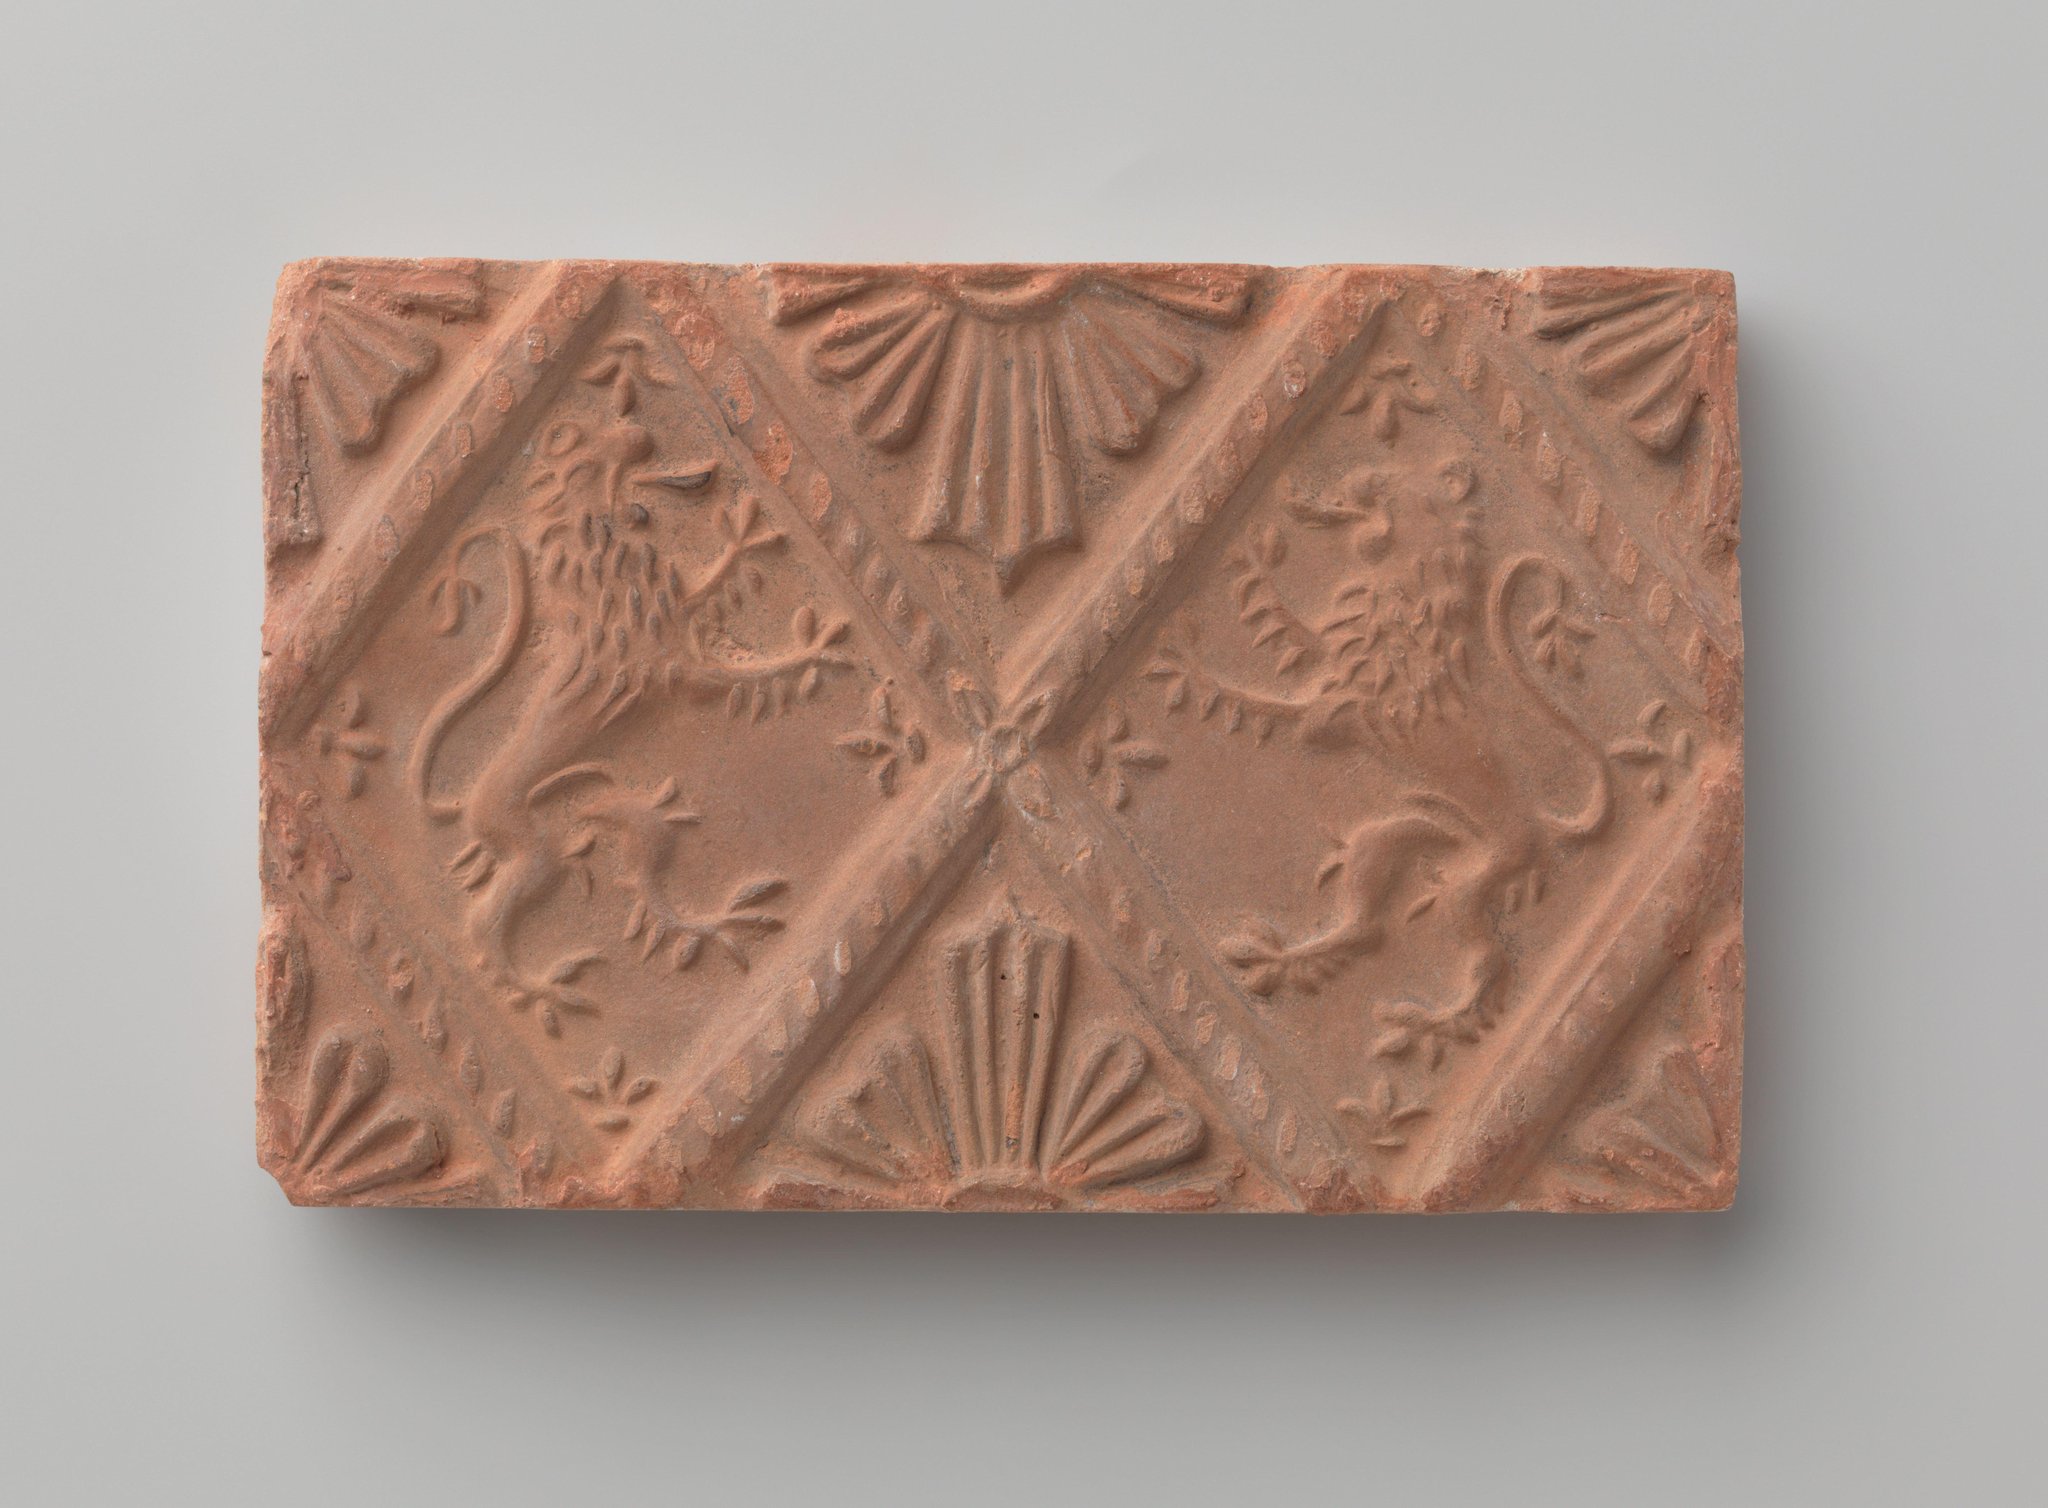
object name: hearthstone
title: Haardsteen met voorstelling van twee klimmende leeuwen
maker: Anonymous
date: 1875-1900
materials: earthenware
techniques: printing, firing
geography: netherlands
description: Haardsteen met voorstelling van twee klimmende leeuwen, geplaatst in geprofileerde ruit. De halve ruiten aan de boven- en onderkant zijn opgevuld met stermotief.